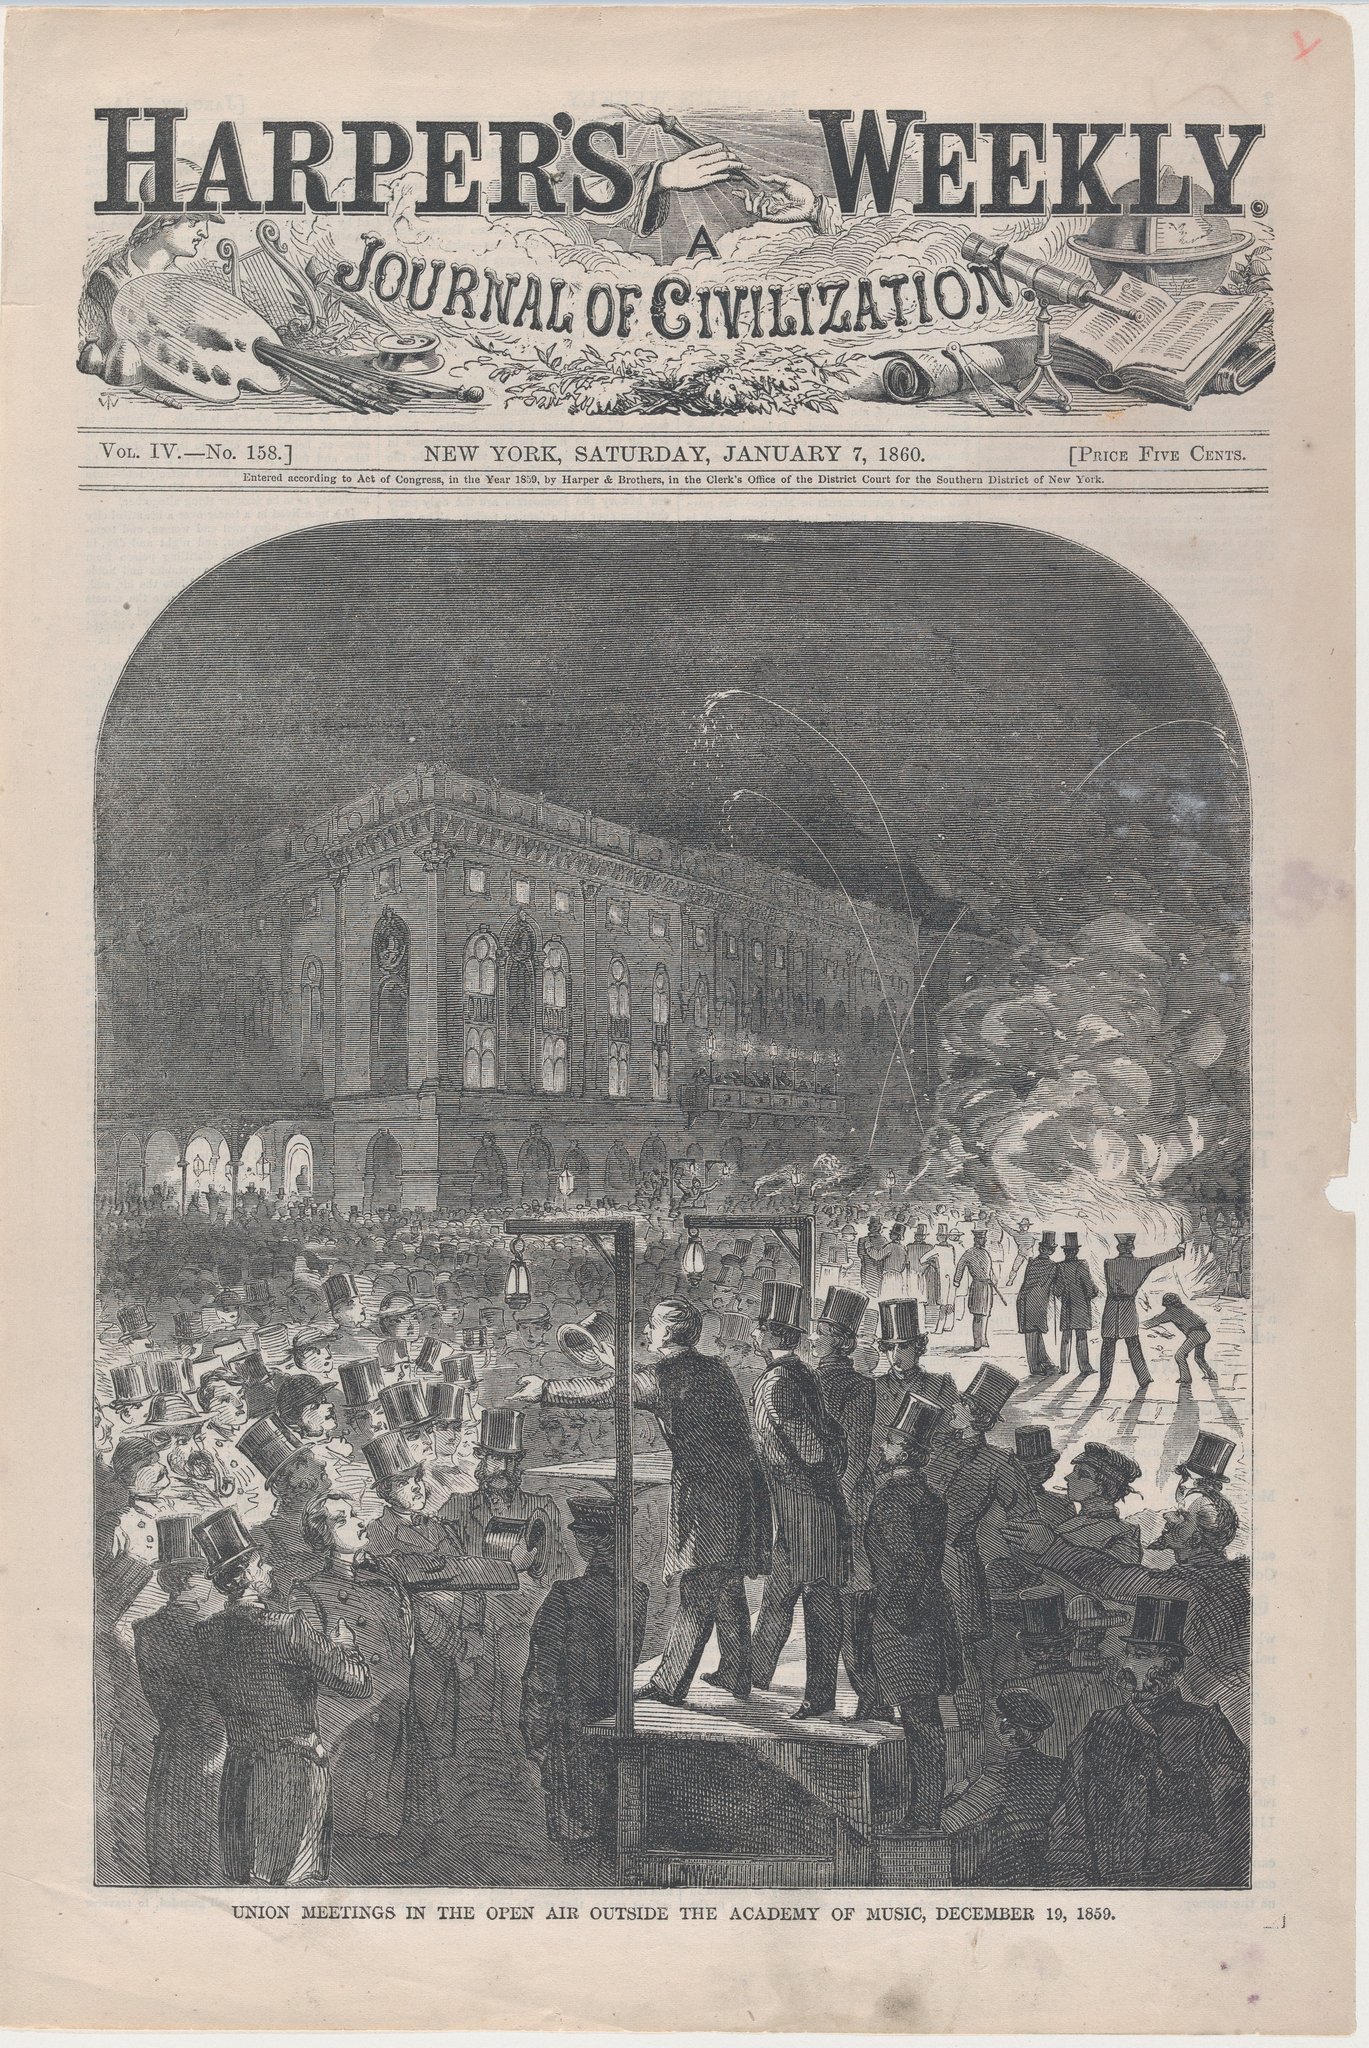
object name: print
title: Union Meetings in the Open Air Outside the Academy of Music, December 19, 1859 (from "Harper's Weekly," Vol. III)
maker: winslow homer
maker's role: artist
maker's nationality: american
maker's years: 1836-1910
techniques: engraving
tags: american civil war,men,crowd